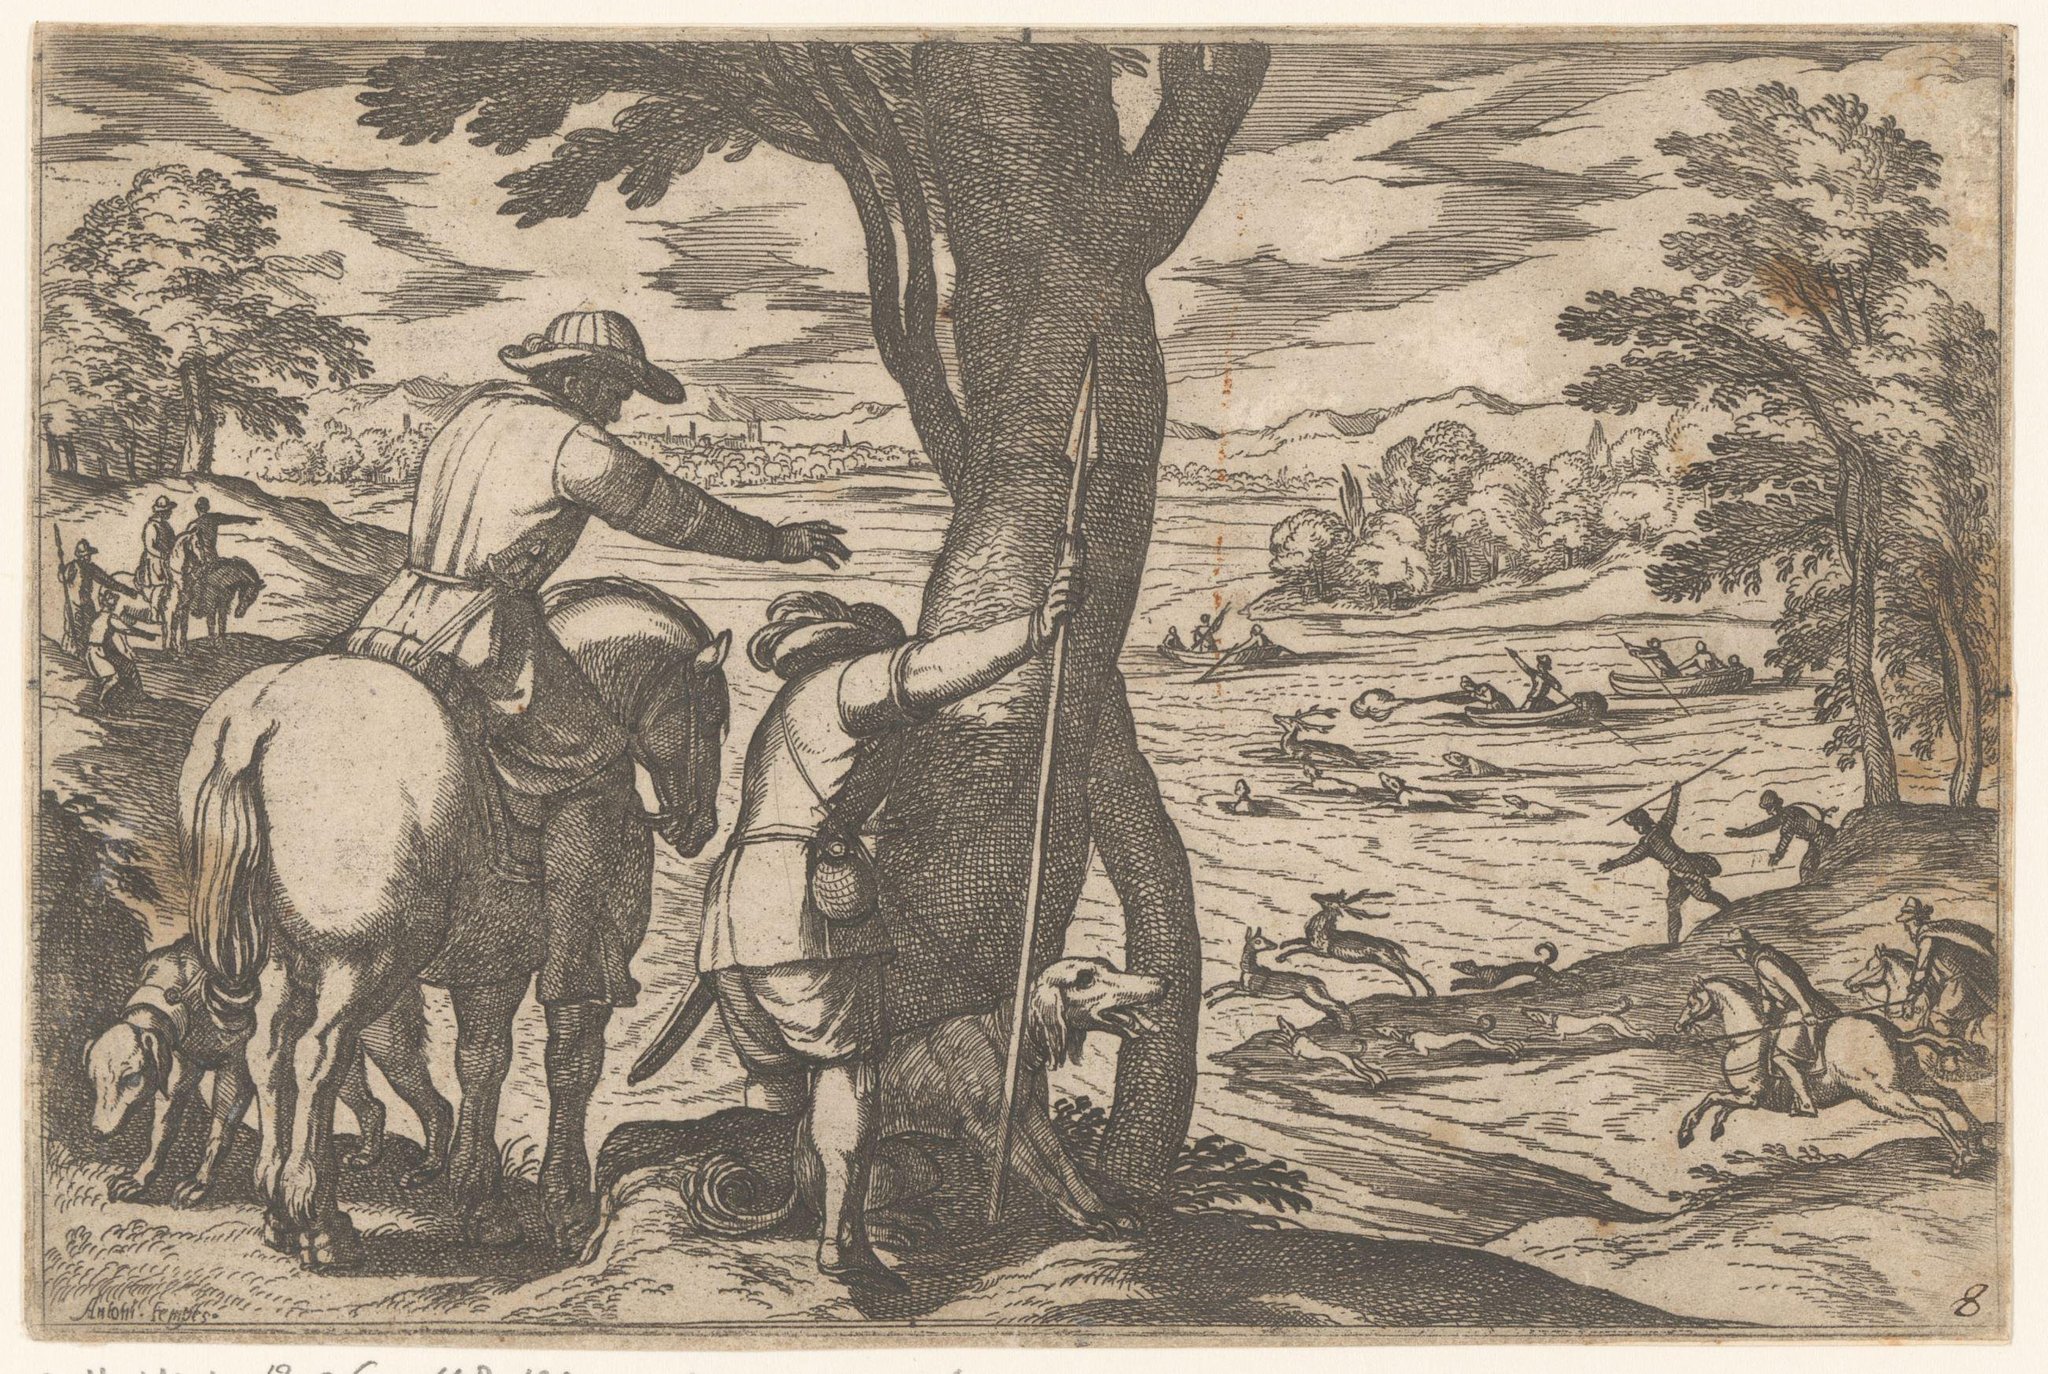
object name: print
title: Jachten op herten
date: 1595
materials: paper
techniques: etching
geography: rome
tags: stag-hunting, hunter, hunters hunting (n.b.: in 1988-1990 this notation denoted the concept of 43c11421 'hunters resting during the hunt')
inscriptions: number: ‘8’, collector's mark: Lugt 11, collector's mark: ‘Hinloopen’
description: Rivierlandschap met jagers en jachthonden die herten het water in jagen. Op de voorgrond twee jagers op de rug gezien.